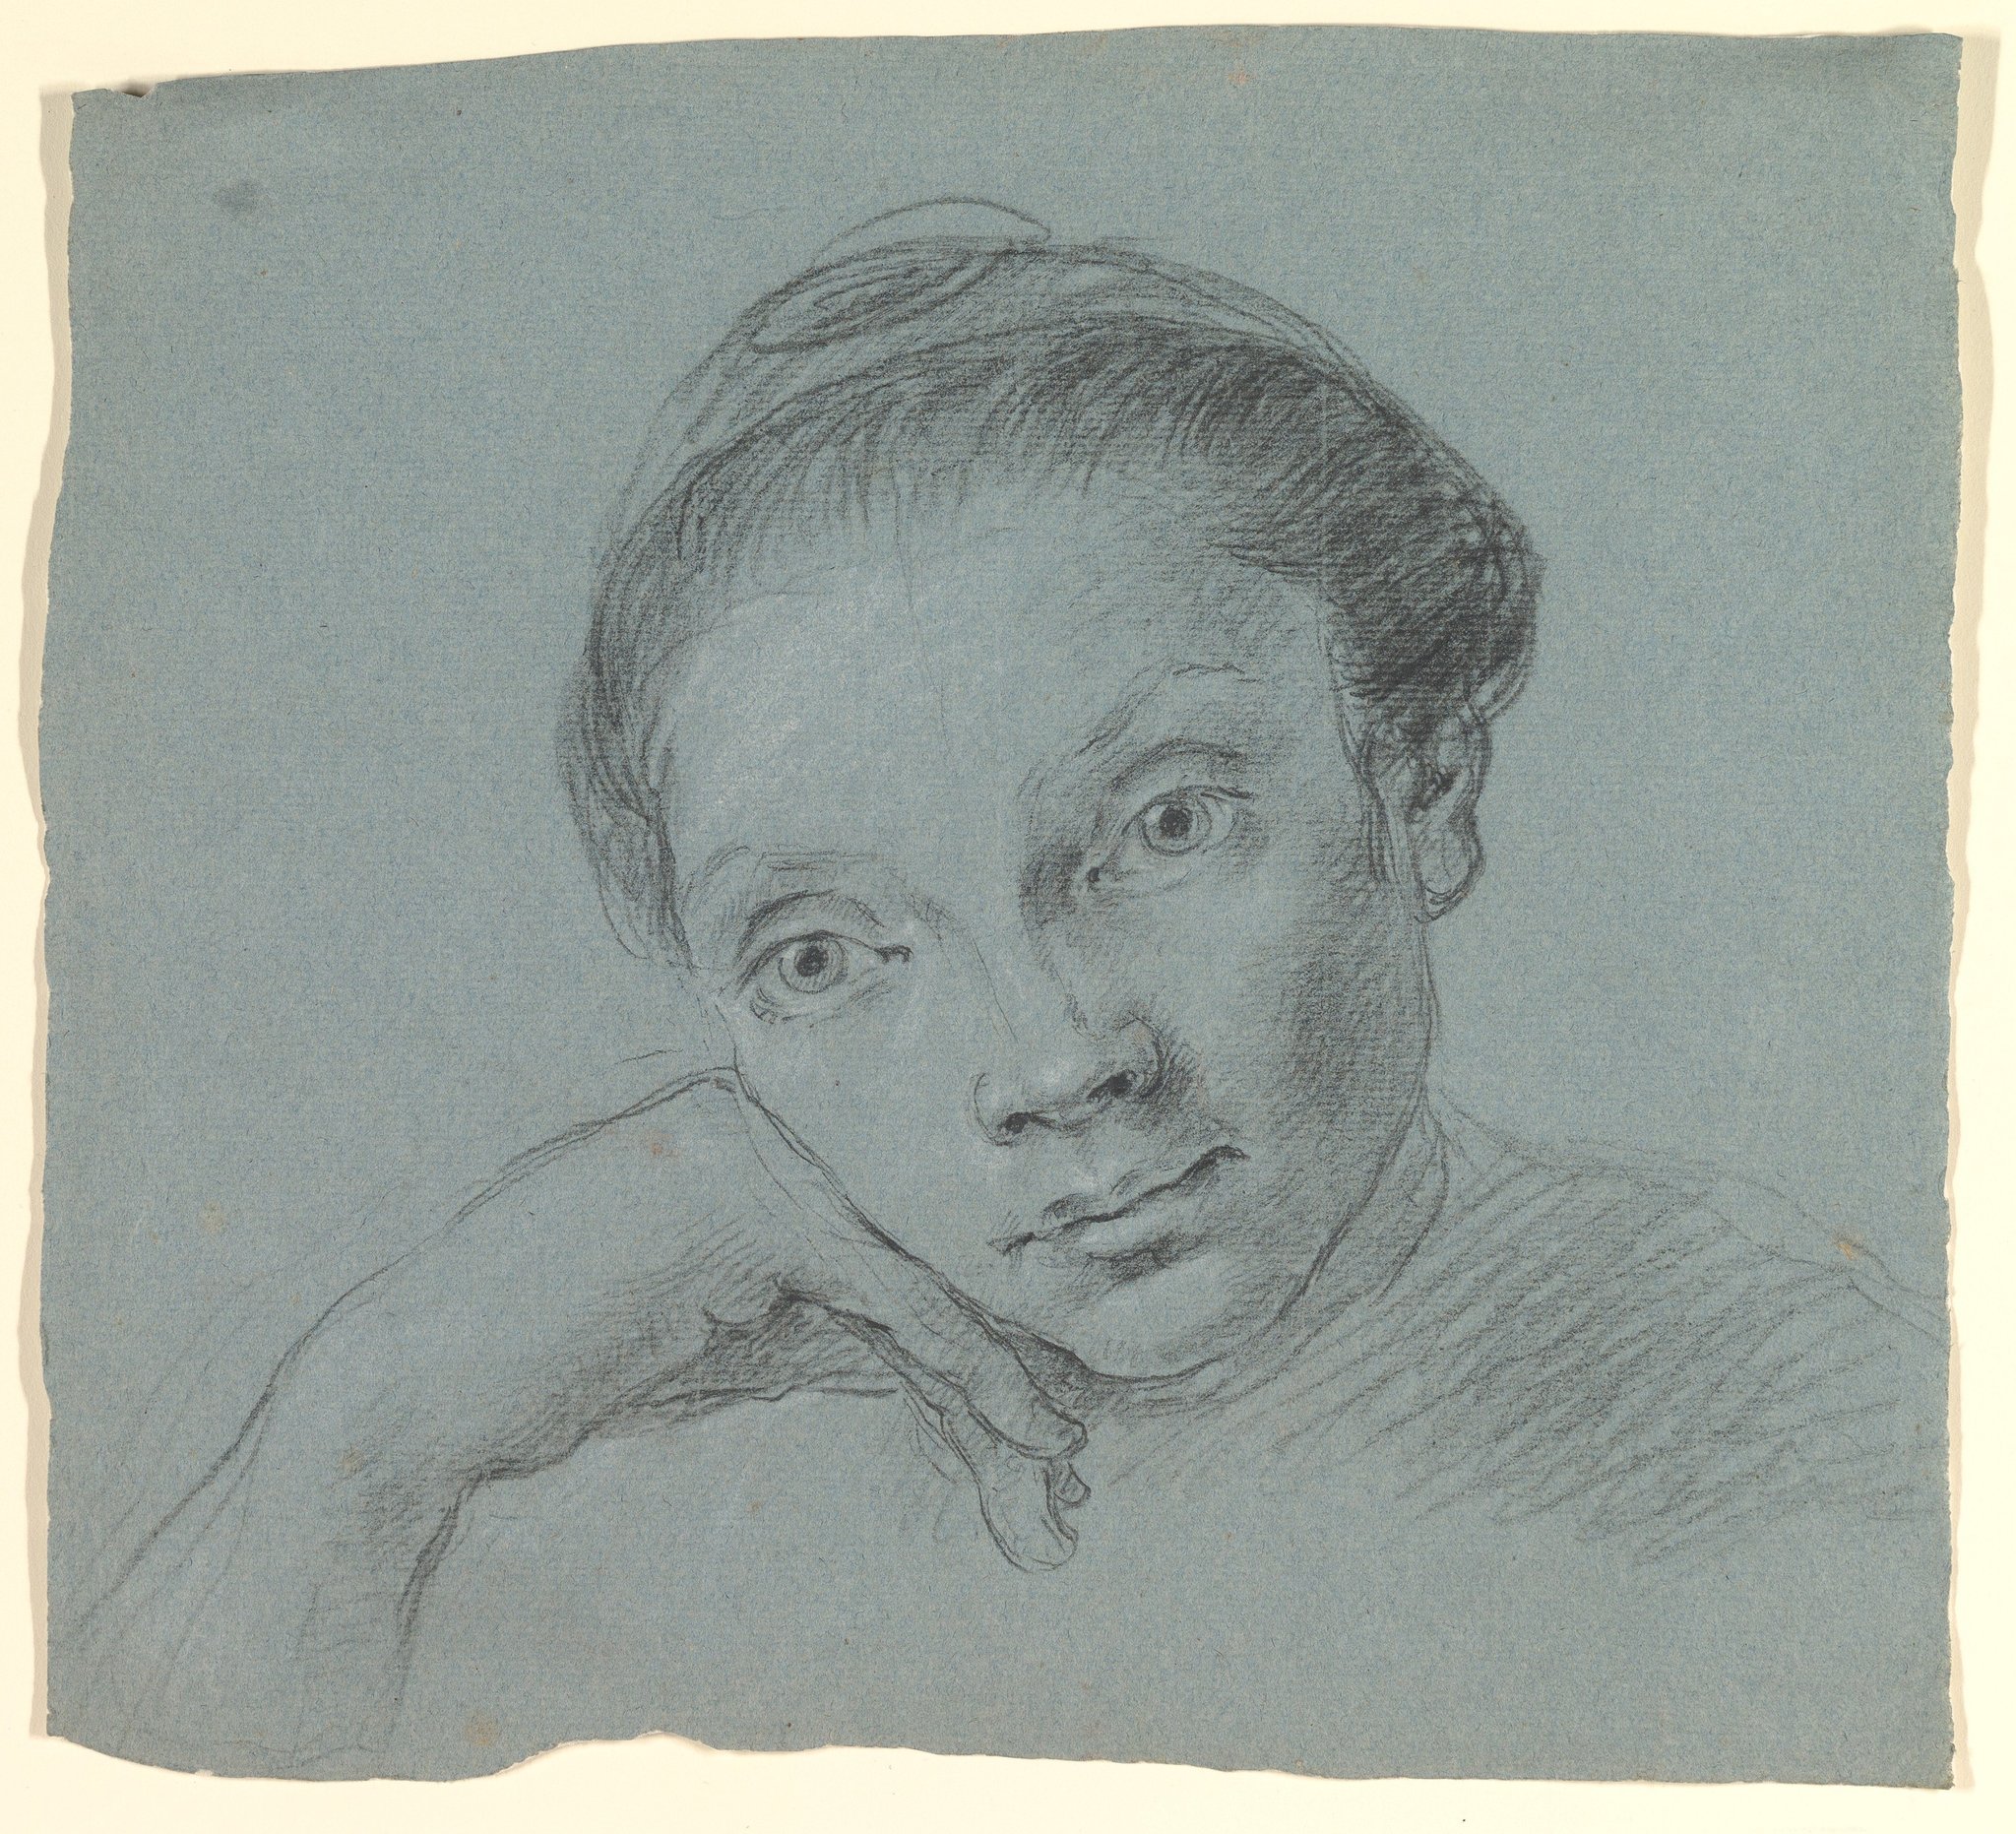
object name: drawing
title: Study of a Woman in Bust-Length Three-Quarter View (recto); Summary Sketch of the Same (verso).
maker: anonymous, italian, north italy, 18th century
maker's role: artist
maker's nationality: italian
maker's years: 1700-1800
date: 1701-1800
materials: chalk, paper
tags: portraits,women